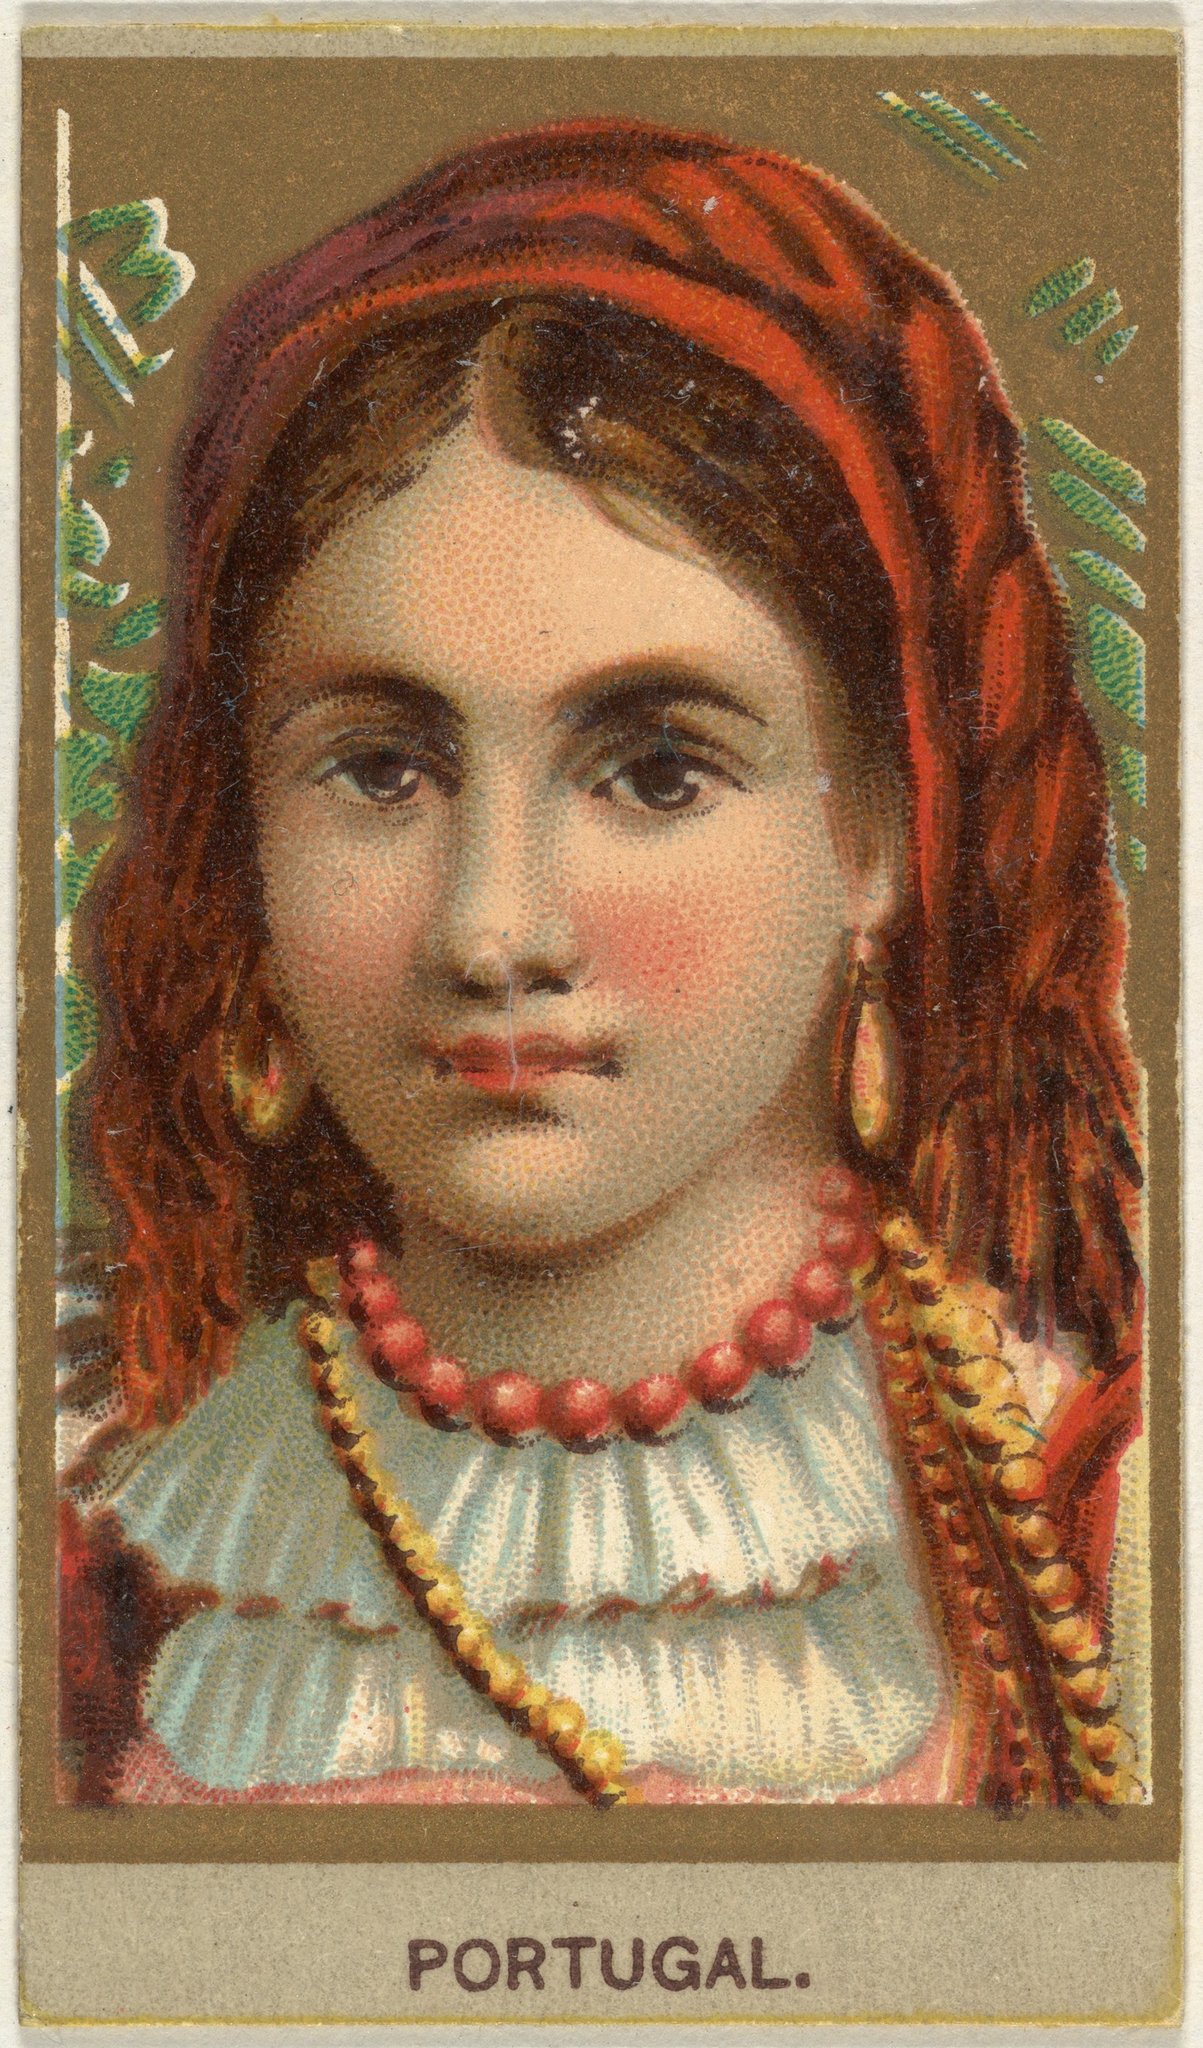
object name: print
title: Portugal, from the Races of Mankind series (T181) issued by Abdul Cigarettes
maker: abdul cigarettes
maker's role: publisher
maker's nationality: american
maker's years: 1881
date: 1881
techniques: color lithograph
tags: women